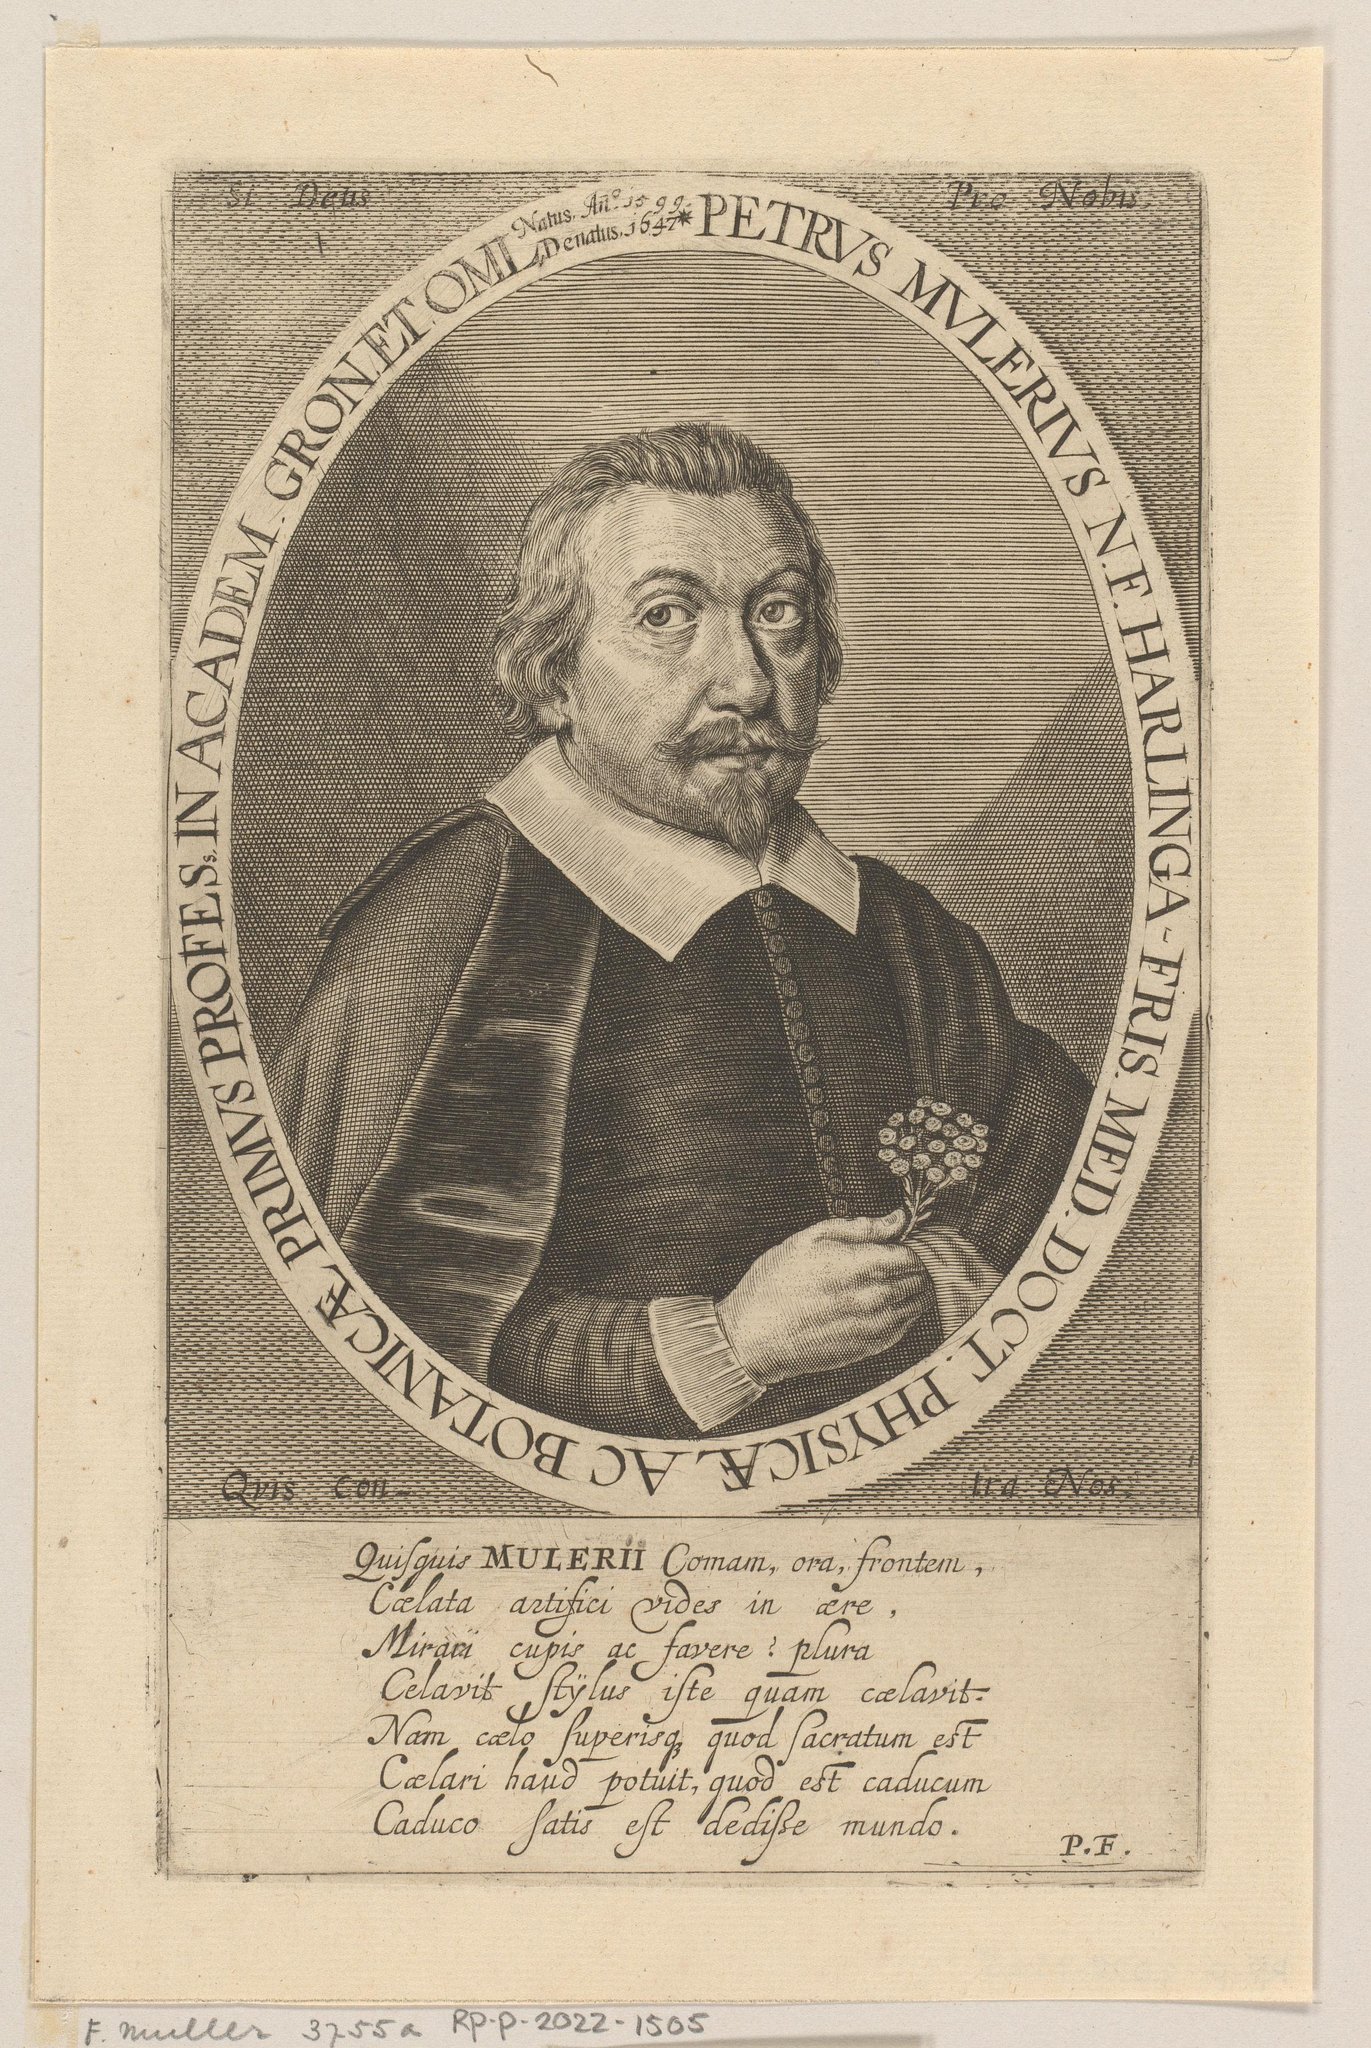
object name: book illustration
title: Petrus Mulerius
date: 1654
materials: paper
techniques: engraving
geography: utrecht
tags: historical persons, professor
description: Prent waarschijnlijk uit: Effigies & vitae Professorvm Academiae Groningae & Omlandiae. Groningen: Hindrick Lussinck en Jan Claessen, 1654.